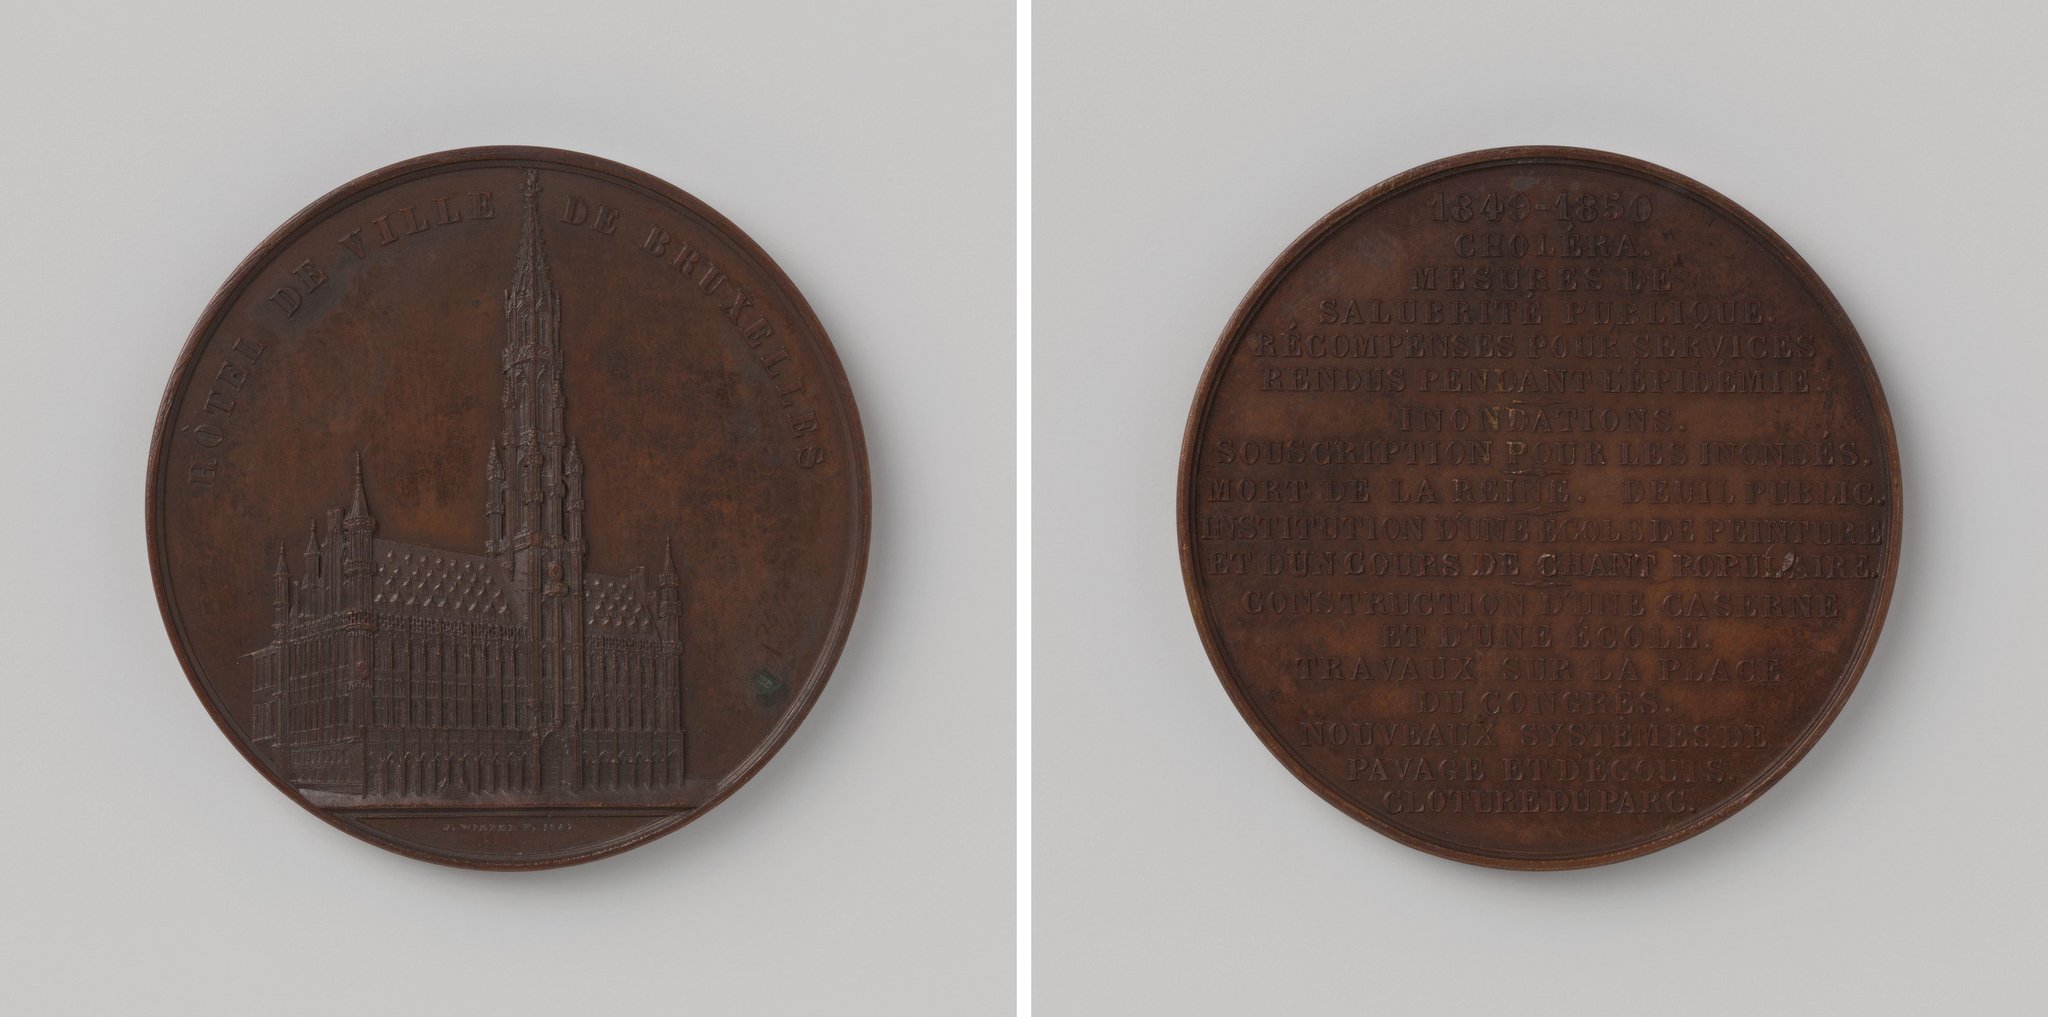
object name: history medal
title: Gebeurtenissen van de jaren 1849-1850 te Brussel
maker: jacob wiener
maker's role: medailleur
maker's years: 1815-1899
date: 1847-1850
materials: bronze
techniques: striking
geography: brussels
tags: stadhuis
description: Bronzen penning. Voorzijde: raadhuis binnen omschrift; afsnede: signatuur. Keerzijde: opschrift.